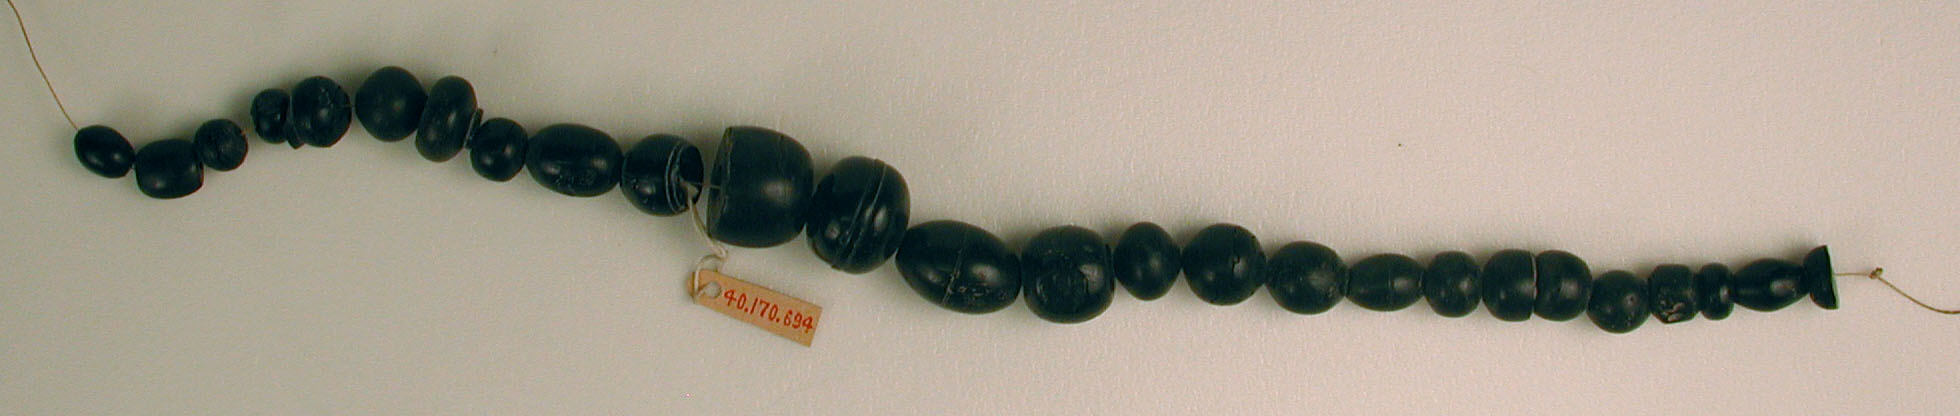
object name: bead, string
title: String of Beads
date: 801-1100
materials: stone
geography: iran